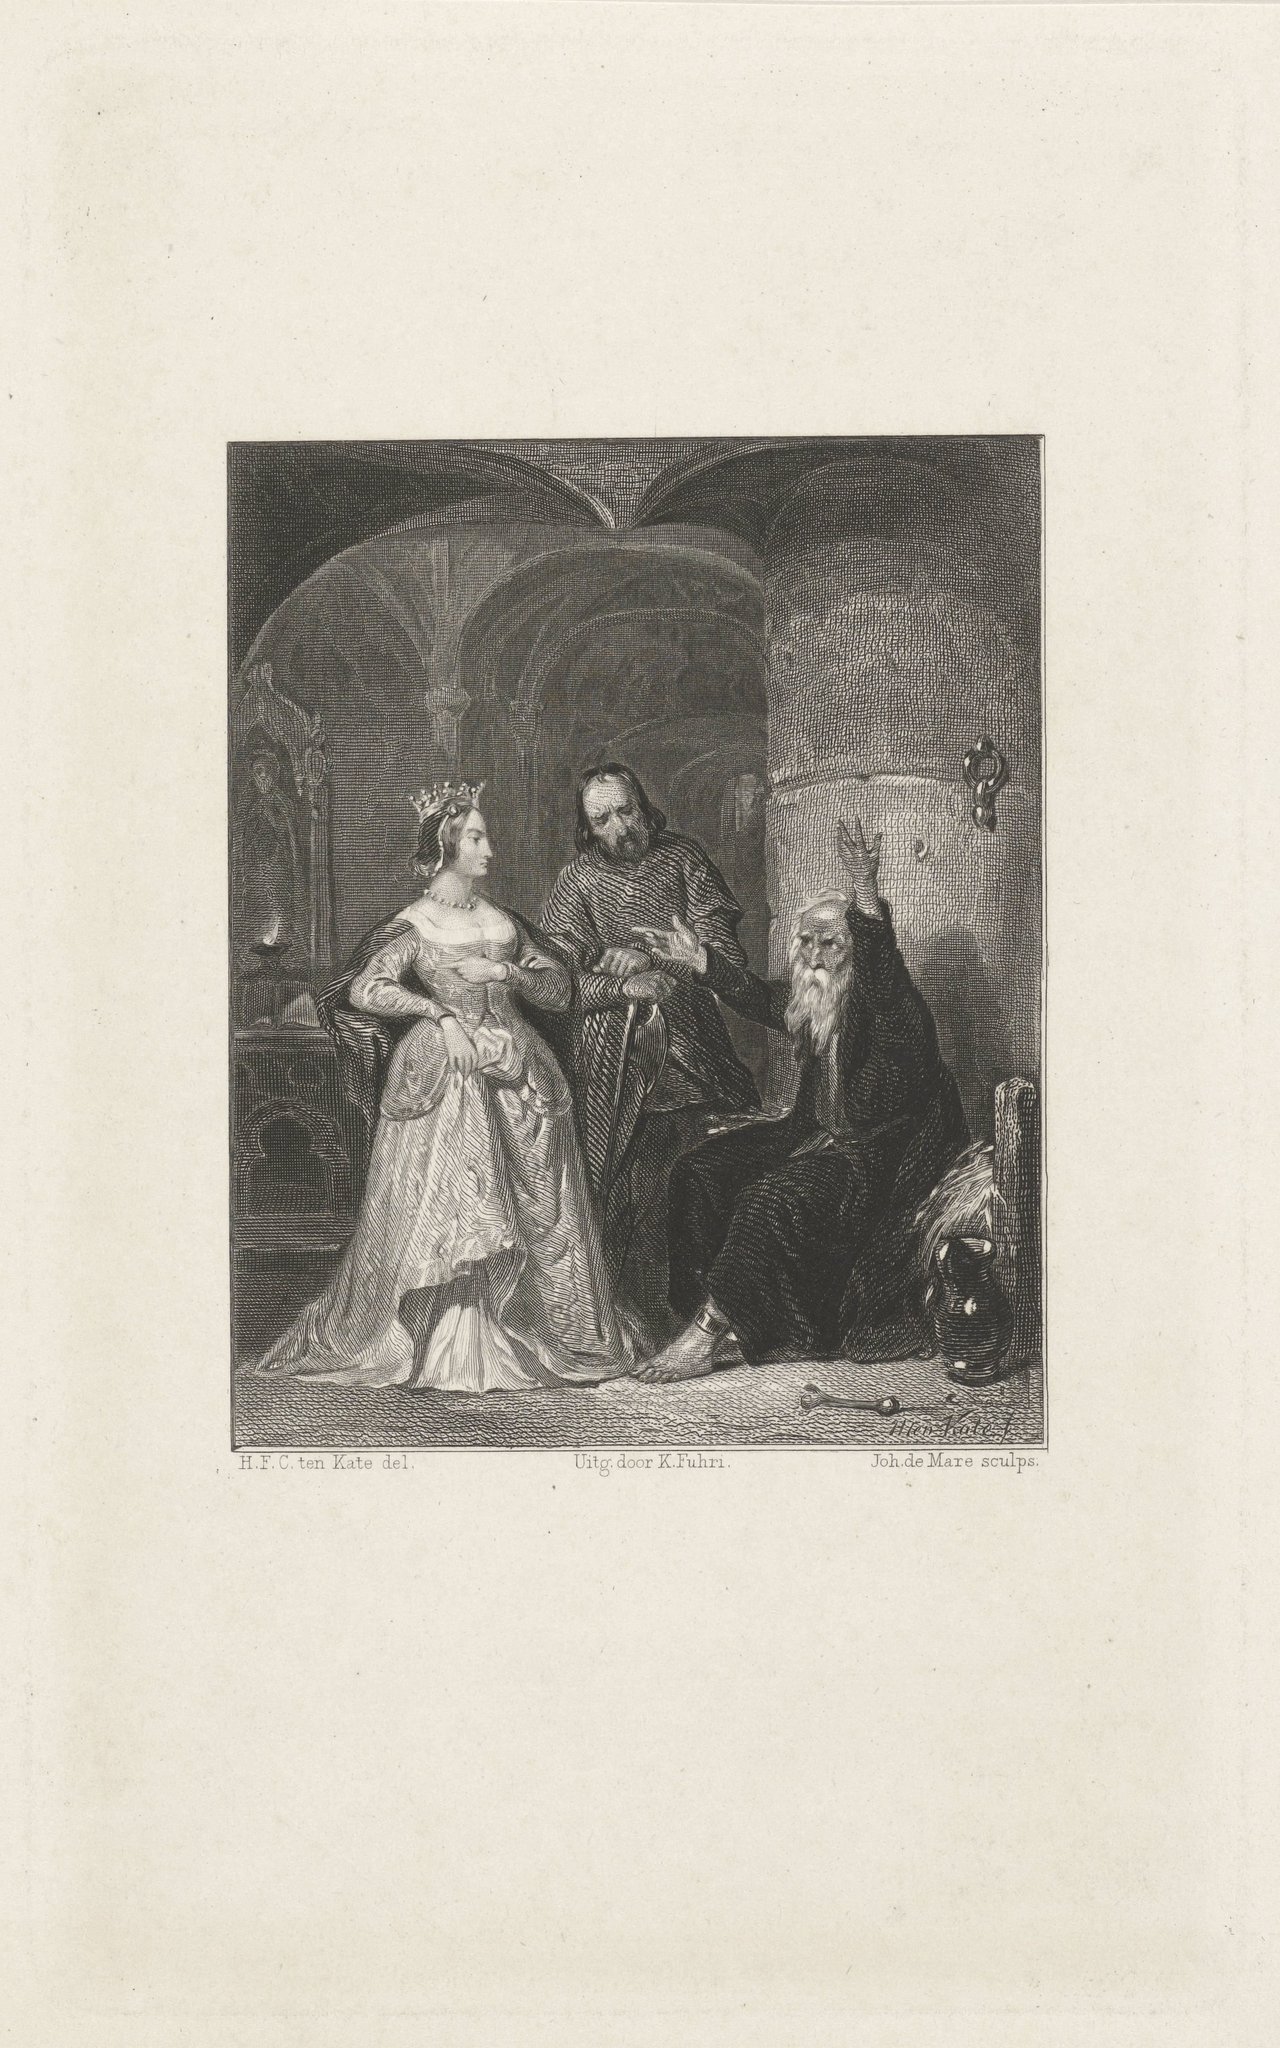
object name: print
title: Gekroonde dame bij een geketende man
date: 1837-1855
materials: paper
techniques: engraving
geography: the hague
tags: ruler, sovereign - bb - female ruler, imprisonment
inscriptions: collector's mark: Lugt 2228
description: Een geketende man met een baard met opgeheven armen bij een man met een bijl en een gekroonde dame in een gewelfd interieur.